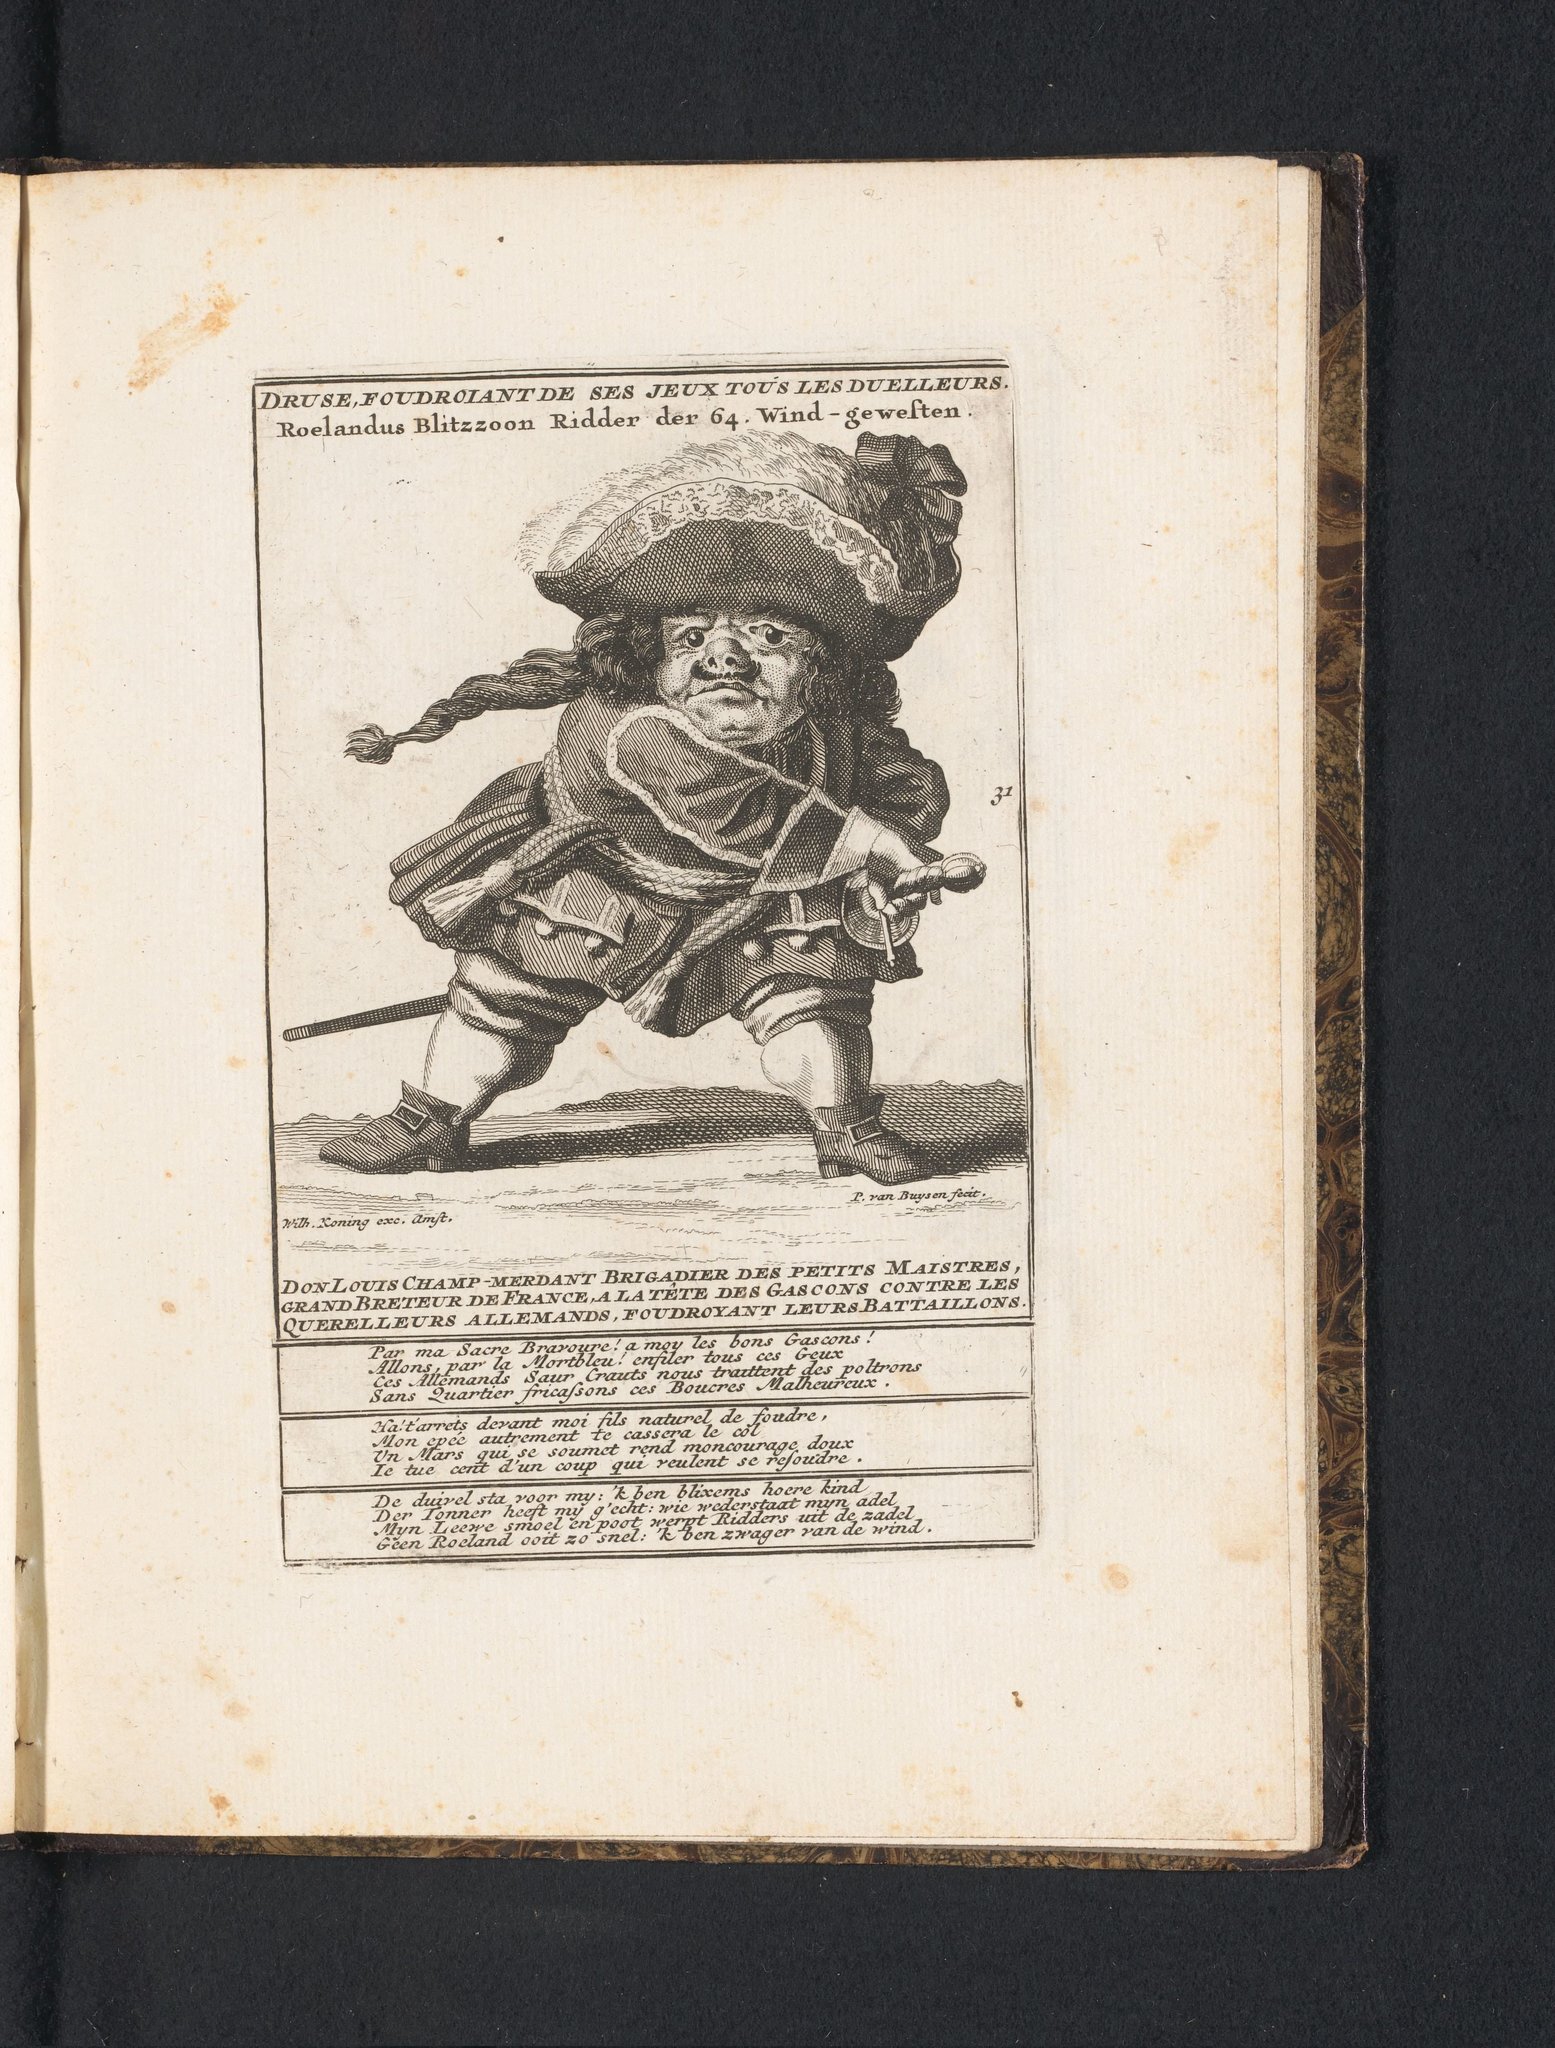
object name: print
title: Bombario Actionist en de Geest van Esopus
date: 1718-1720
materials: paper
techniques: etching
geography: amsterdam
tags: caricatures (human types), little people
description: De kleine mens Roelandus Blitzzoon. In het onderschrift verzen in het Duits, Frans en Nederlands. Genummerd rechts midden: 31. Onderdeel van deel II in de tweede Nederlandse gebonden uitgave uit 1720 (en gerelateerd aan de Windhandel in dat jaar) van een serie karikaturen van kleine mensen, bekend als Het Dwergentooneel.